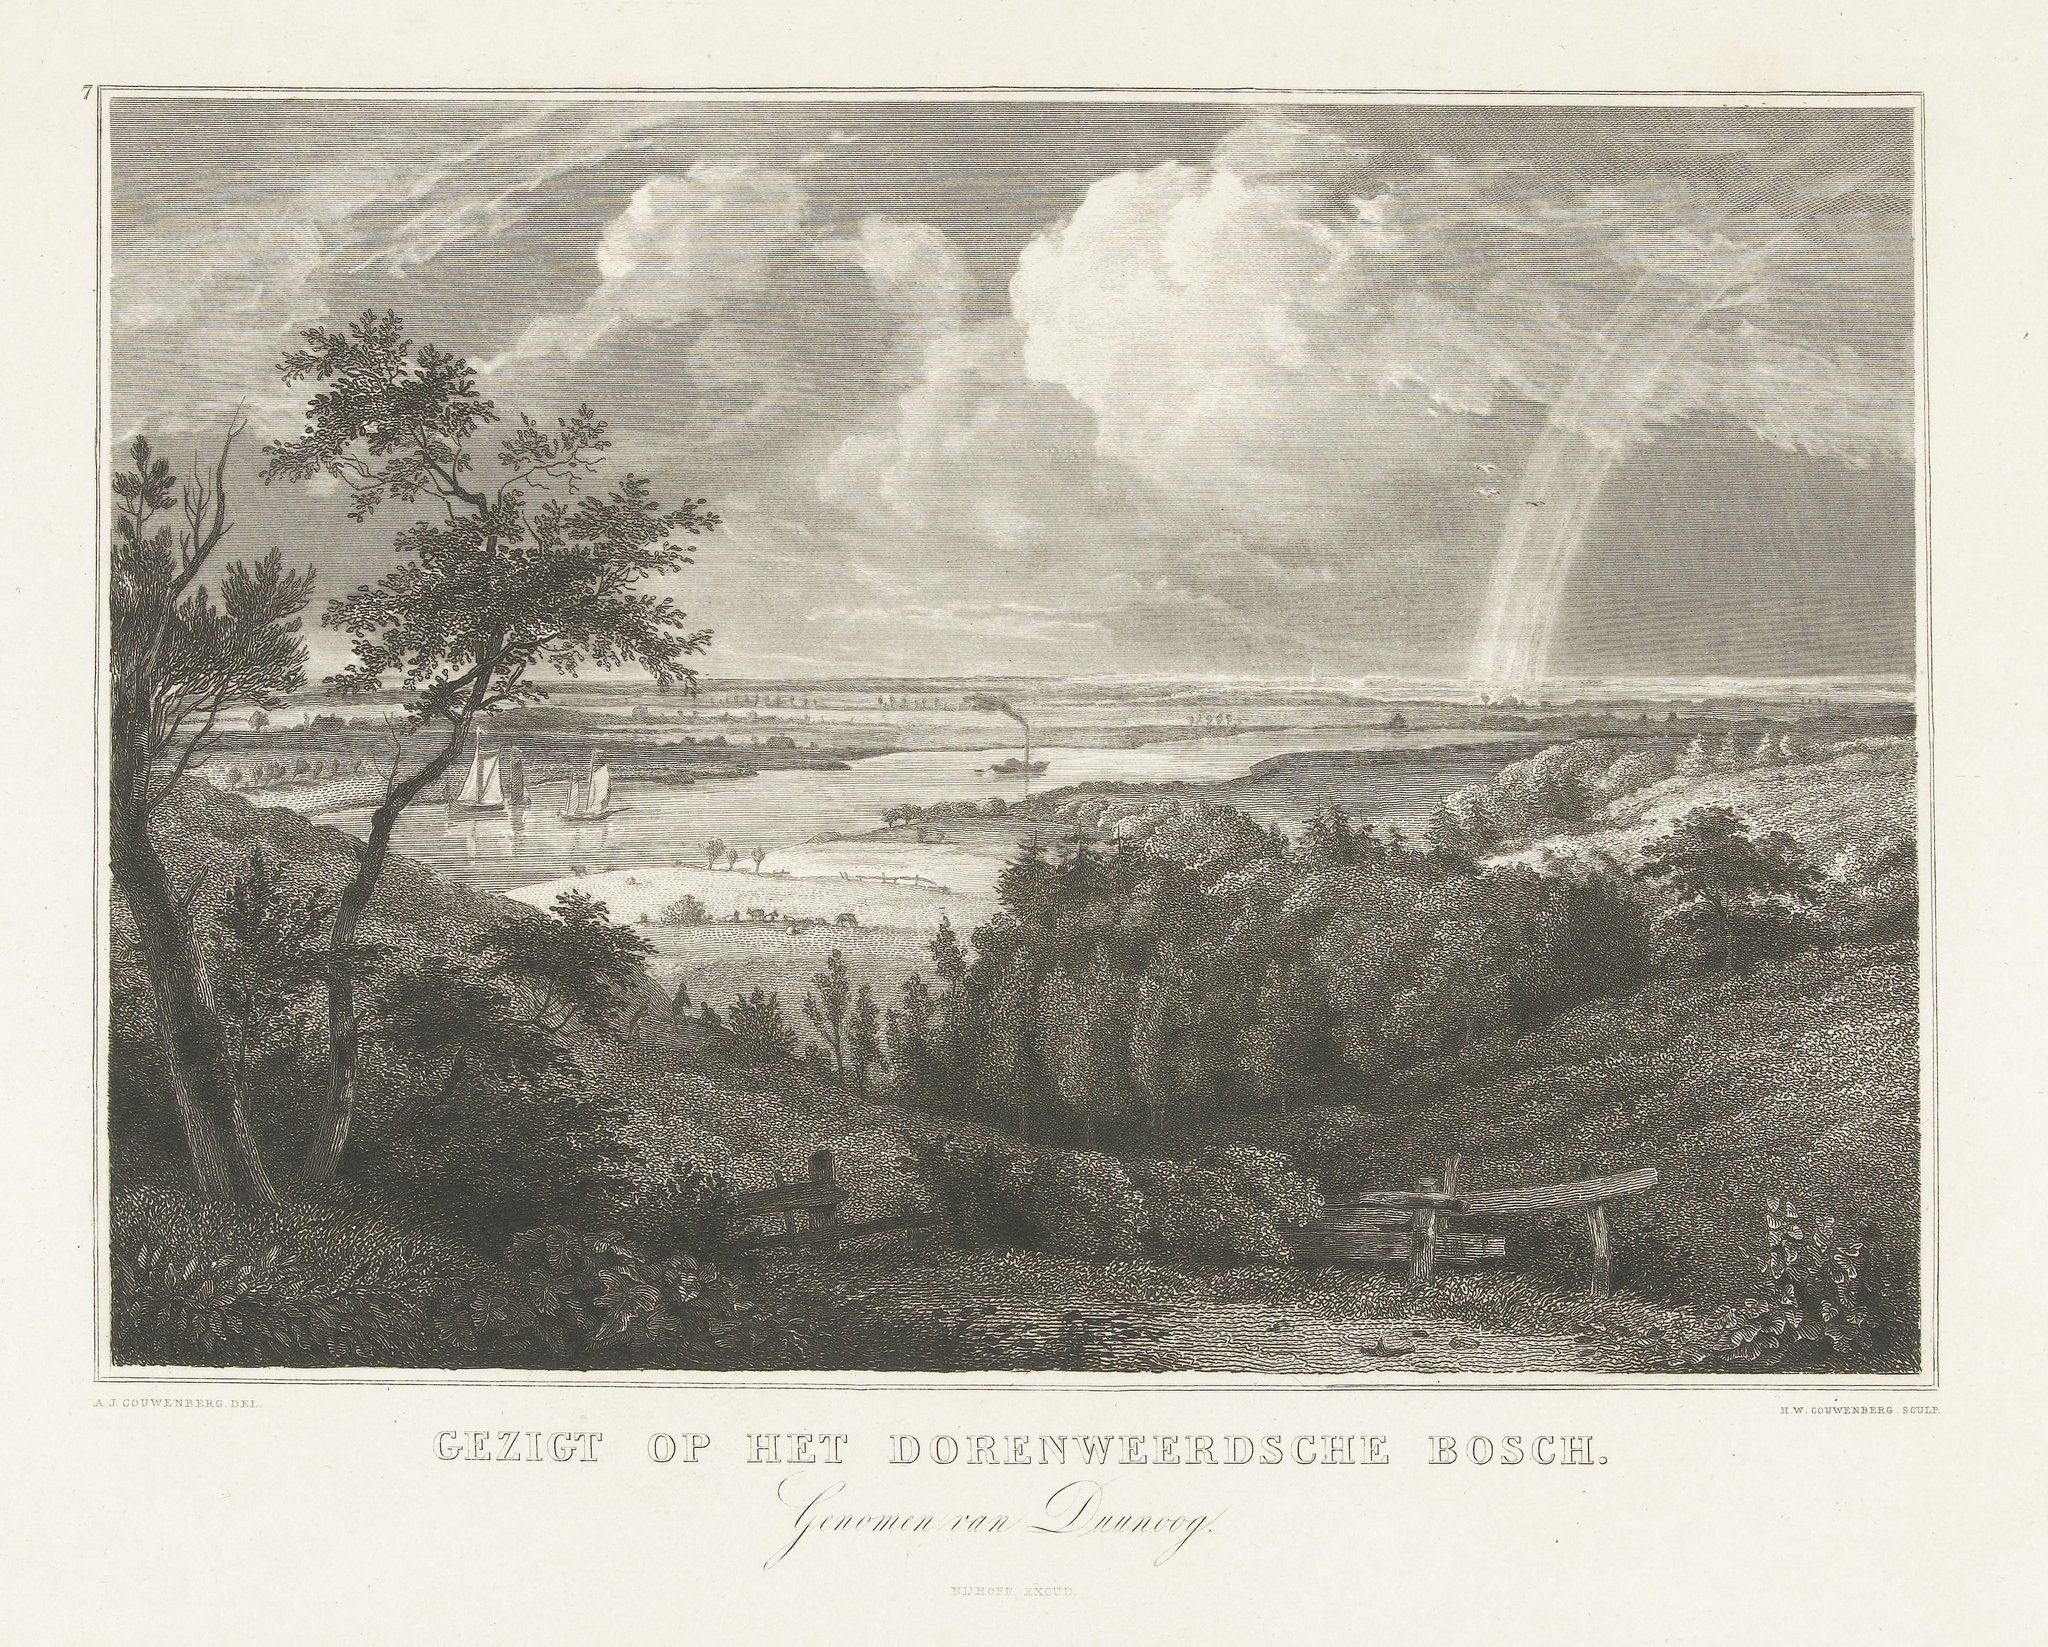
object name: print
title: Gezigt op het Dorenweerdsche Bosch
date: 1838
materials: paper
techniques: engraving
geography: arnhem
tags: river, gelderland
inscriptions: collector's mark: Lugt 2228